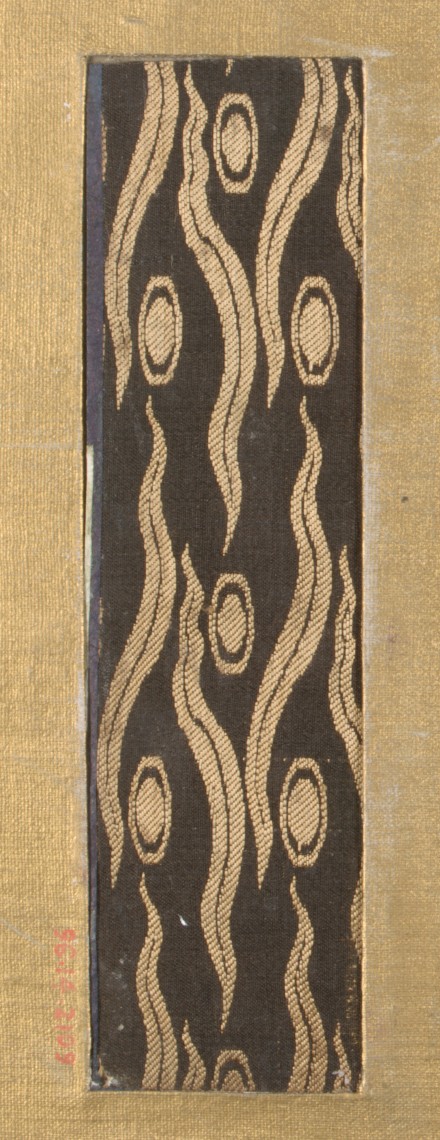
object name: piece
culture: japanese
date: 1701-1900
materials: silk